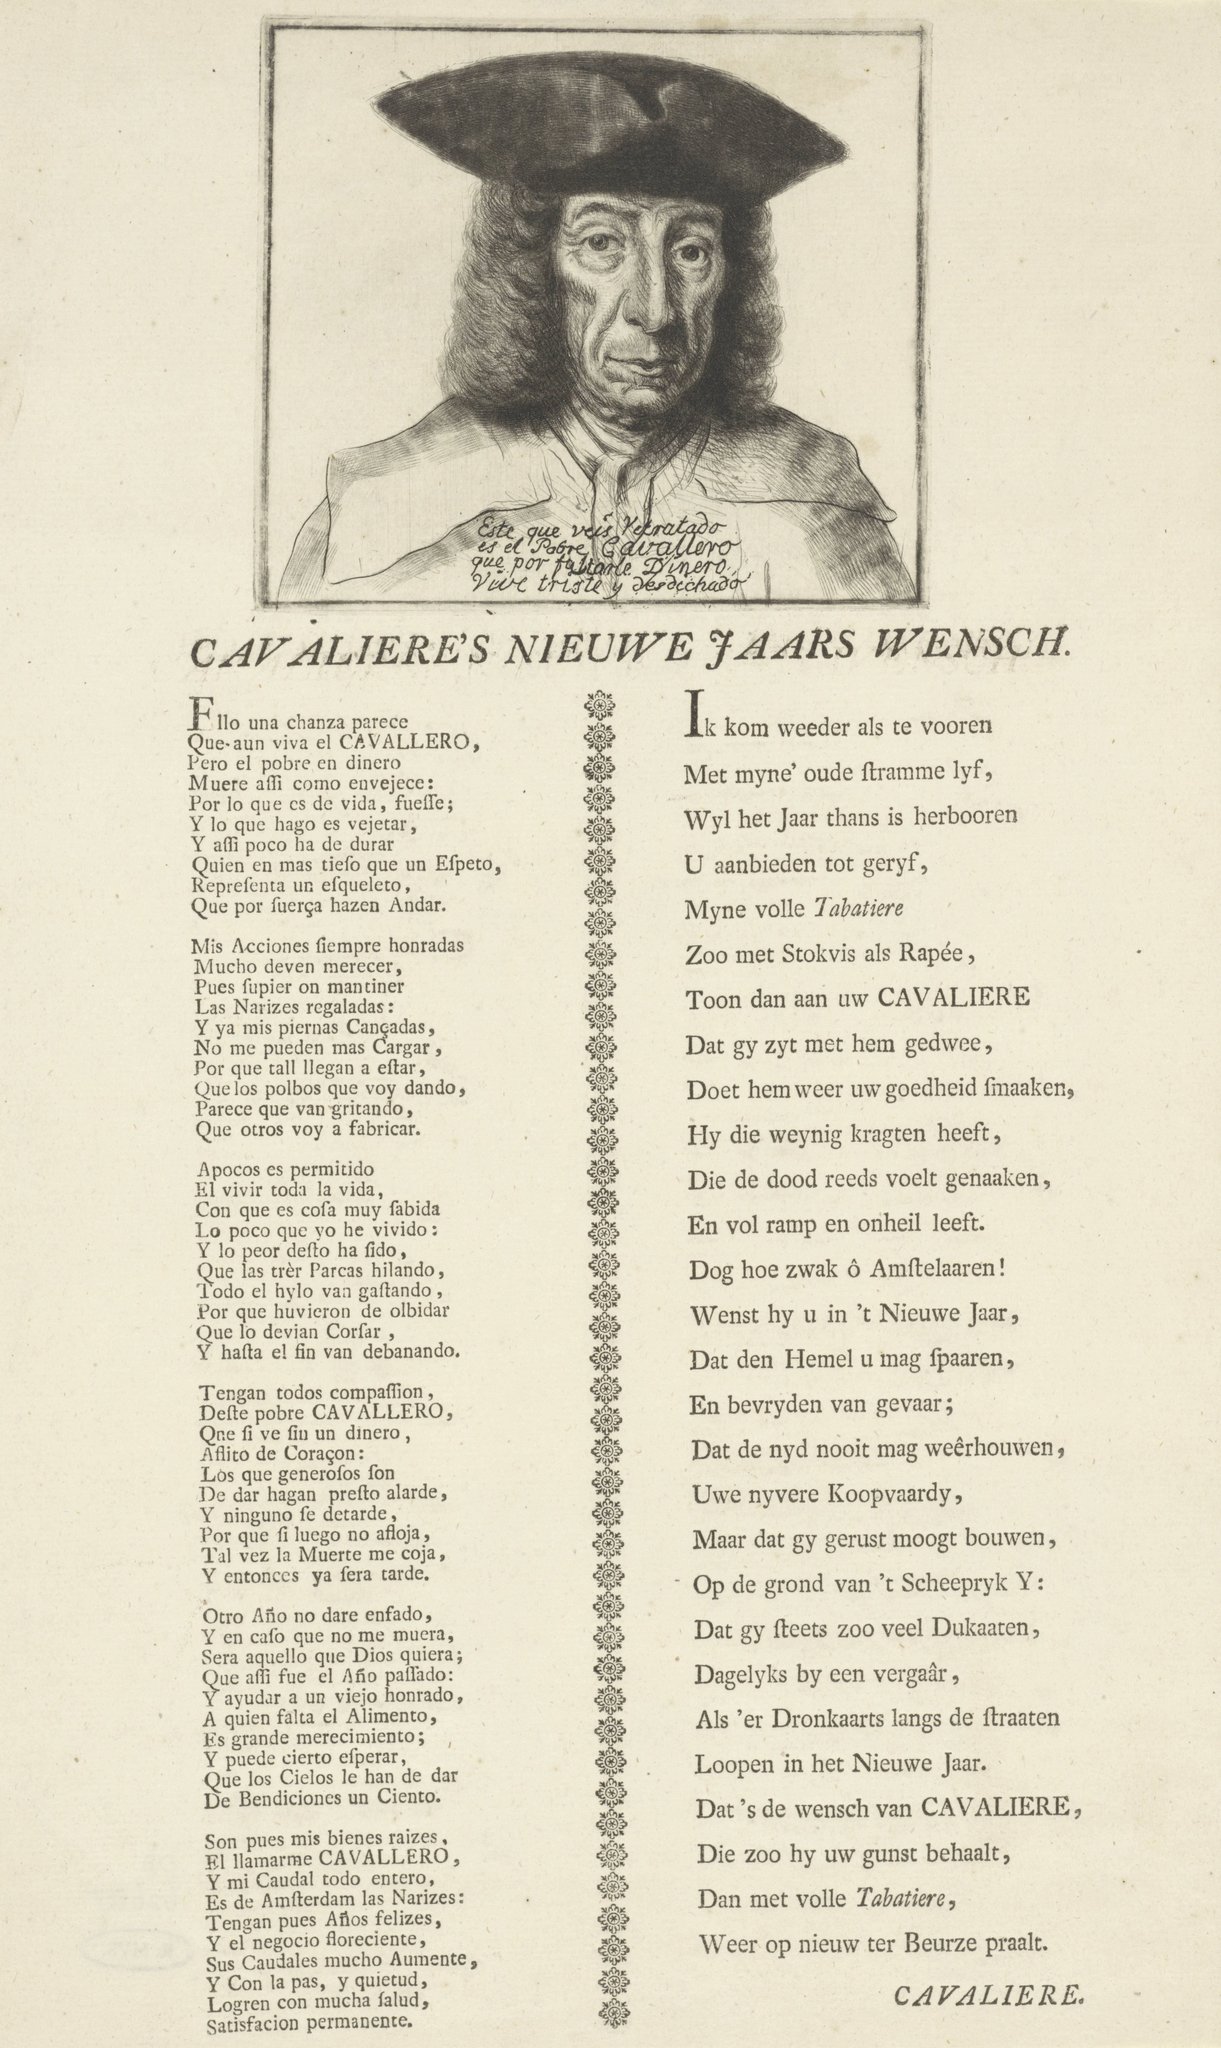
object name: print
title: Cavaliere's Nieuwe Jaars Wensch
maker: reinier vinkeles (i)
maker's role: draughtsman, print maker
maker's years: 1741-1816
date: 1750-1765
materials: paper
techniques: etching, letterpress printing, roulette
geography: amsterdam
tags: portugal, verkoper, cavallero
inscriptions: collector's mark: Lugt 2228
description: Portret van Cavallero, een honderdjarige Portugees Joodse verkoper van snuisterijen op de Amsterdamse beurs. Onder het portret twee kolommen tekst, links in het Portugees en rechts in het Nederlands.